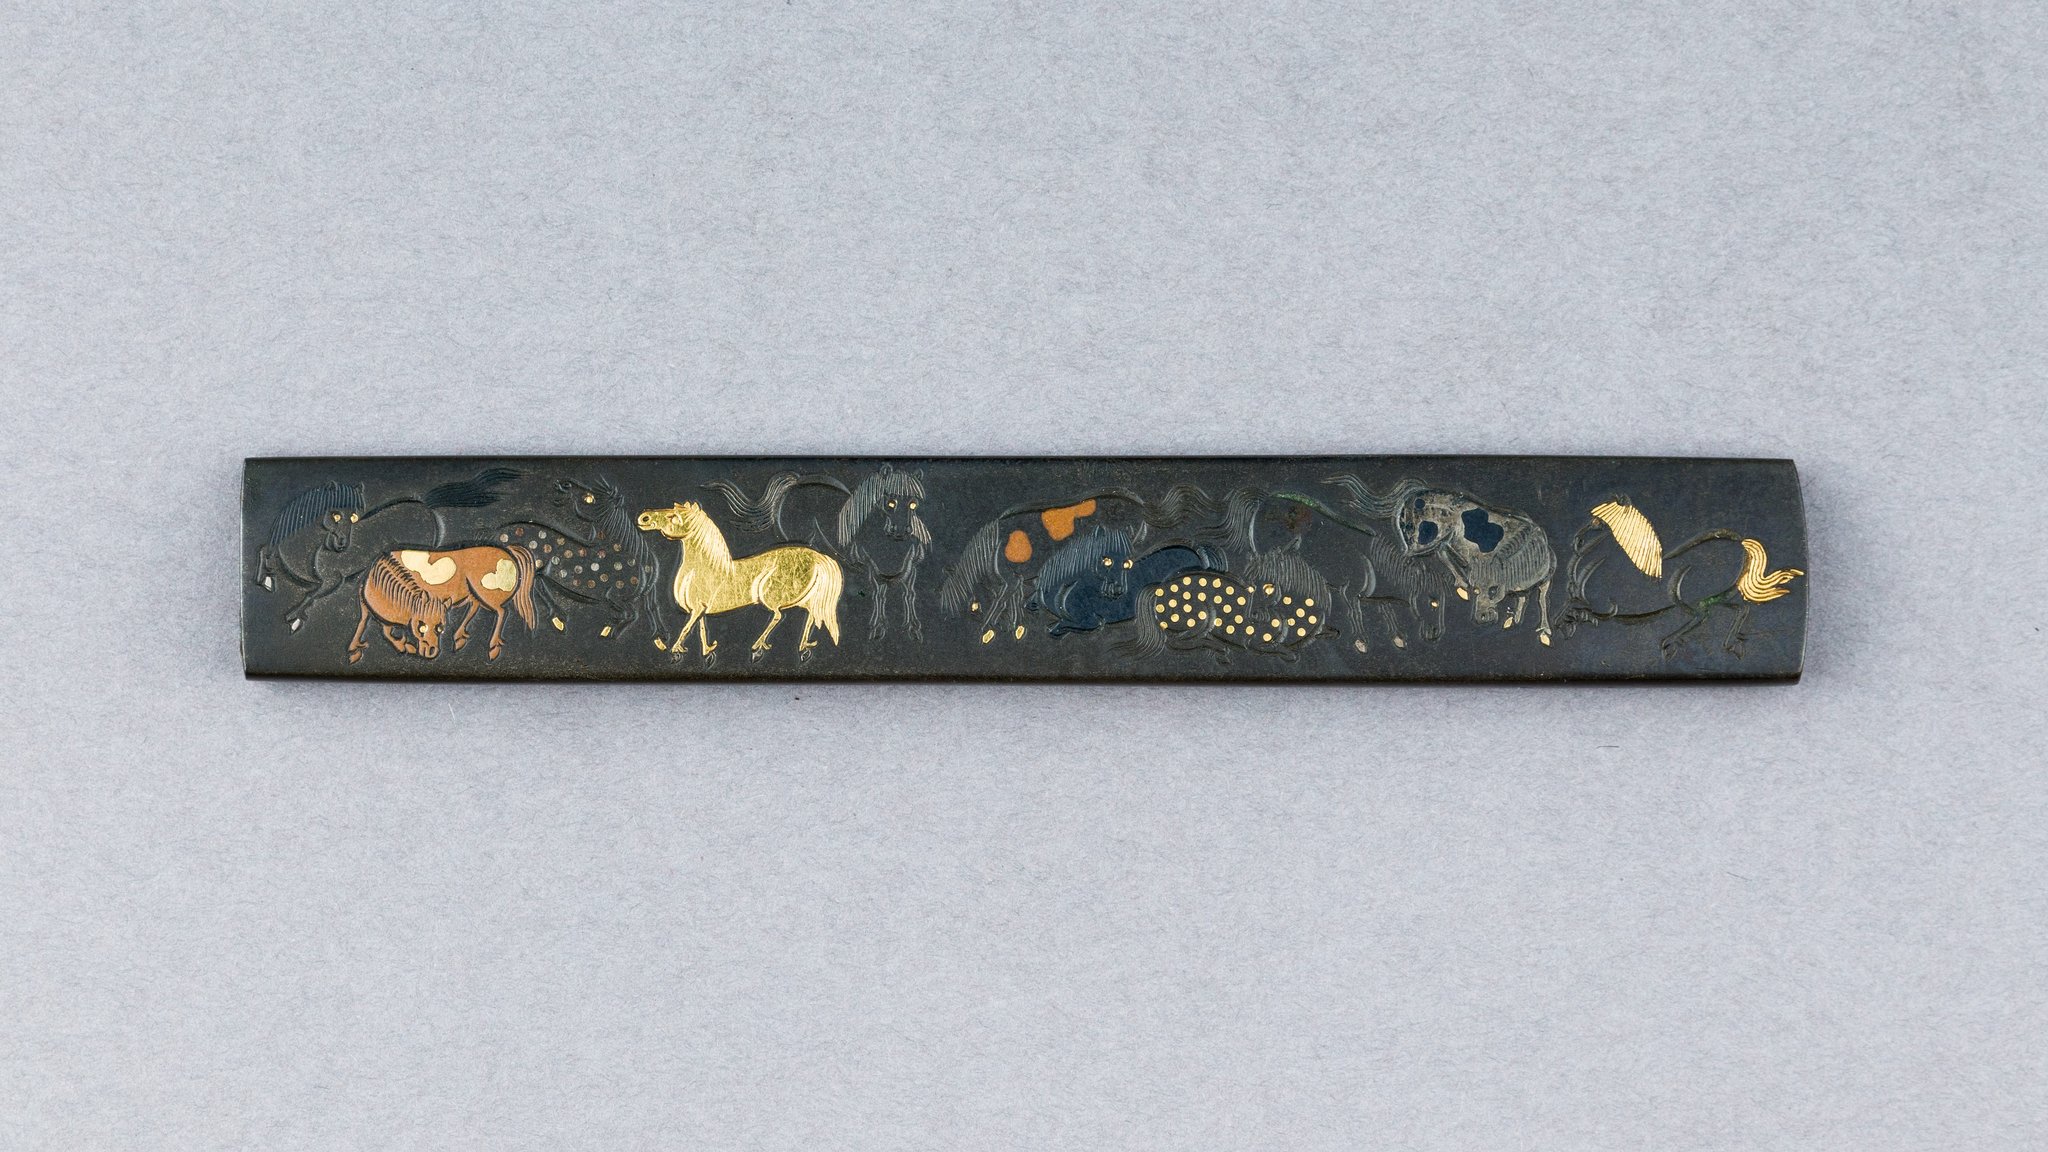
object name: knife handle kozuka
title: Knife Handle (Kozuka)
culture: japanese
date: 1615-1868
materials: copper, gold alloy, silver alloy, gold, silver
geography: japan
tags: horses